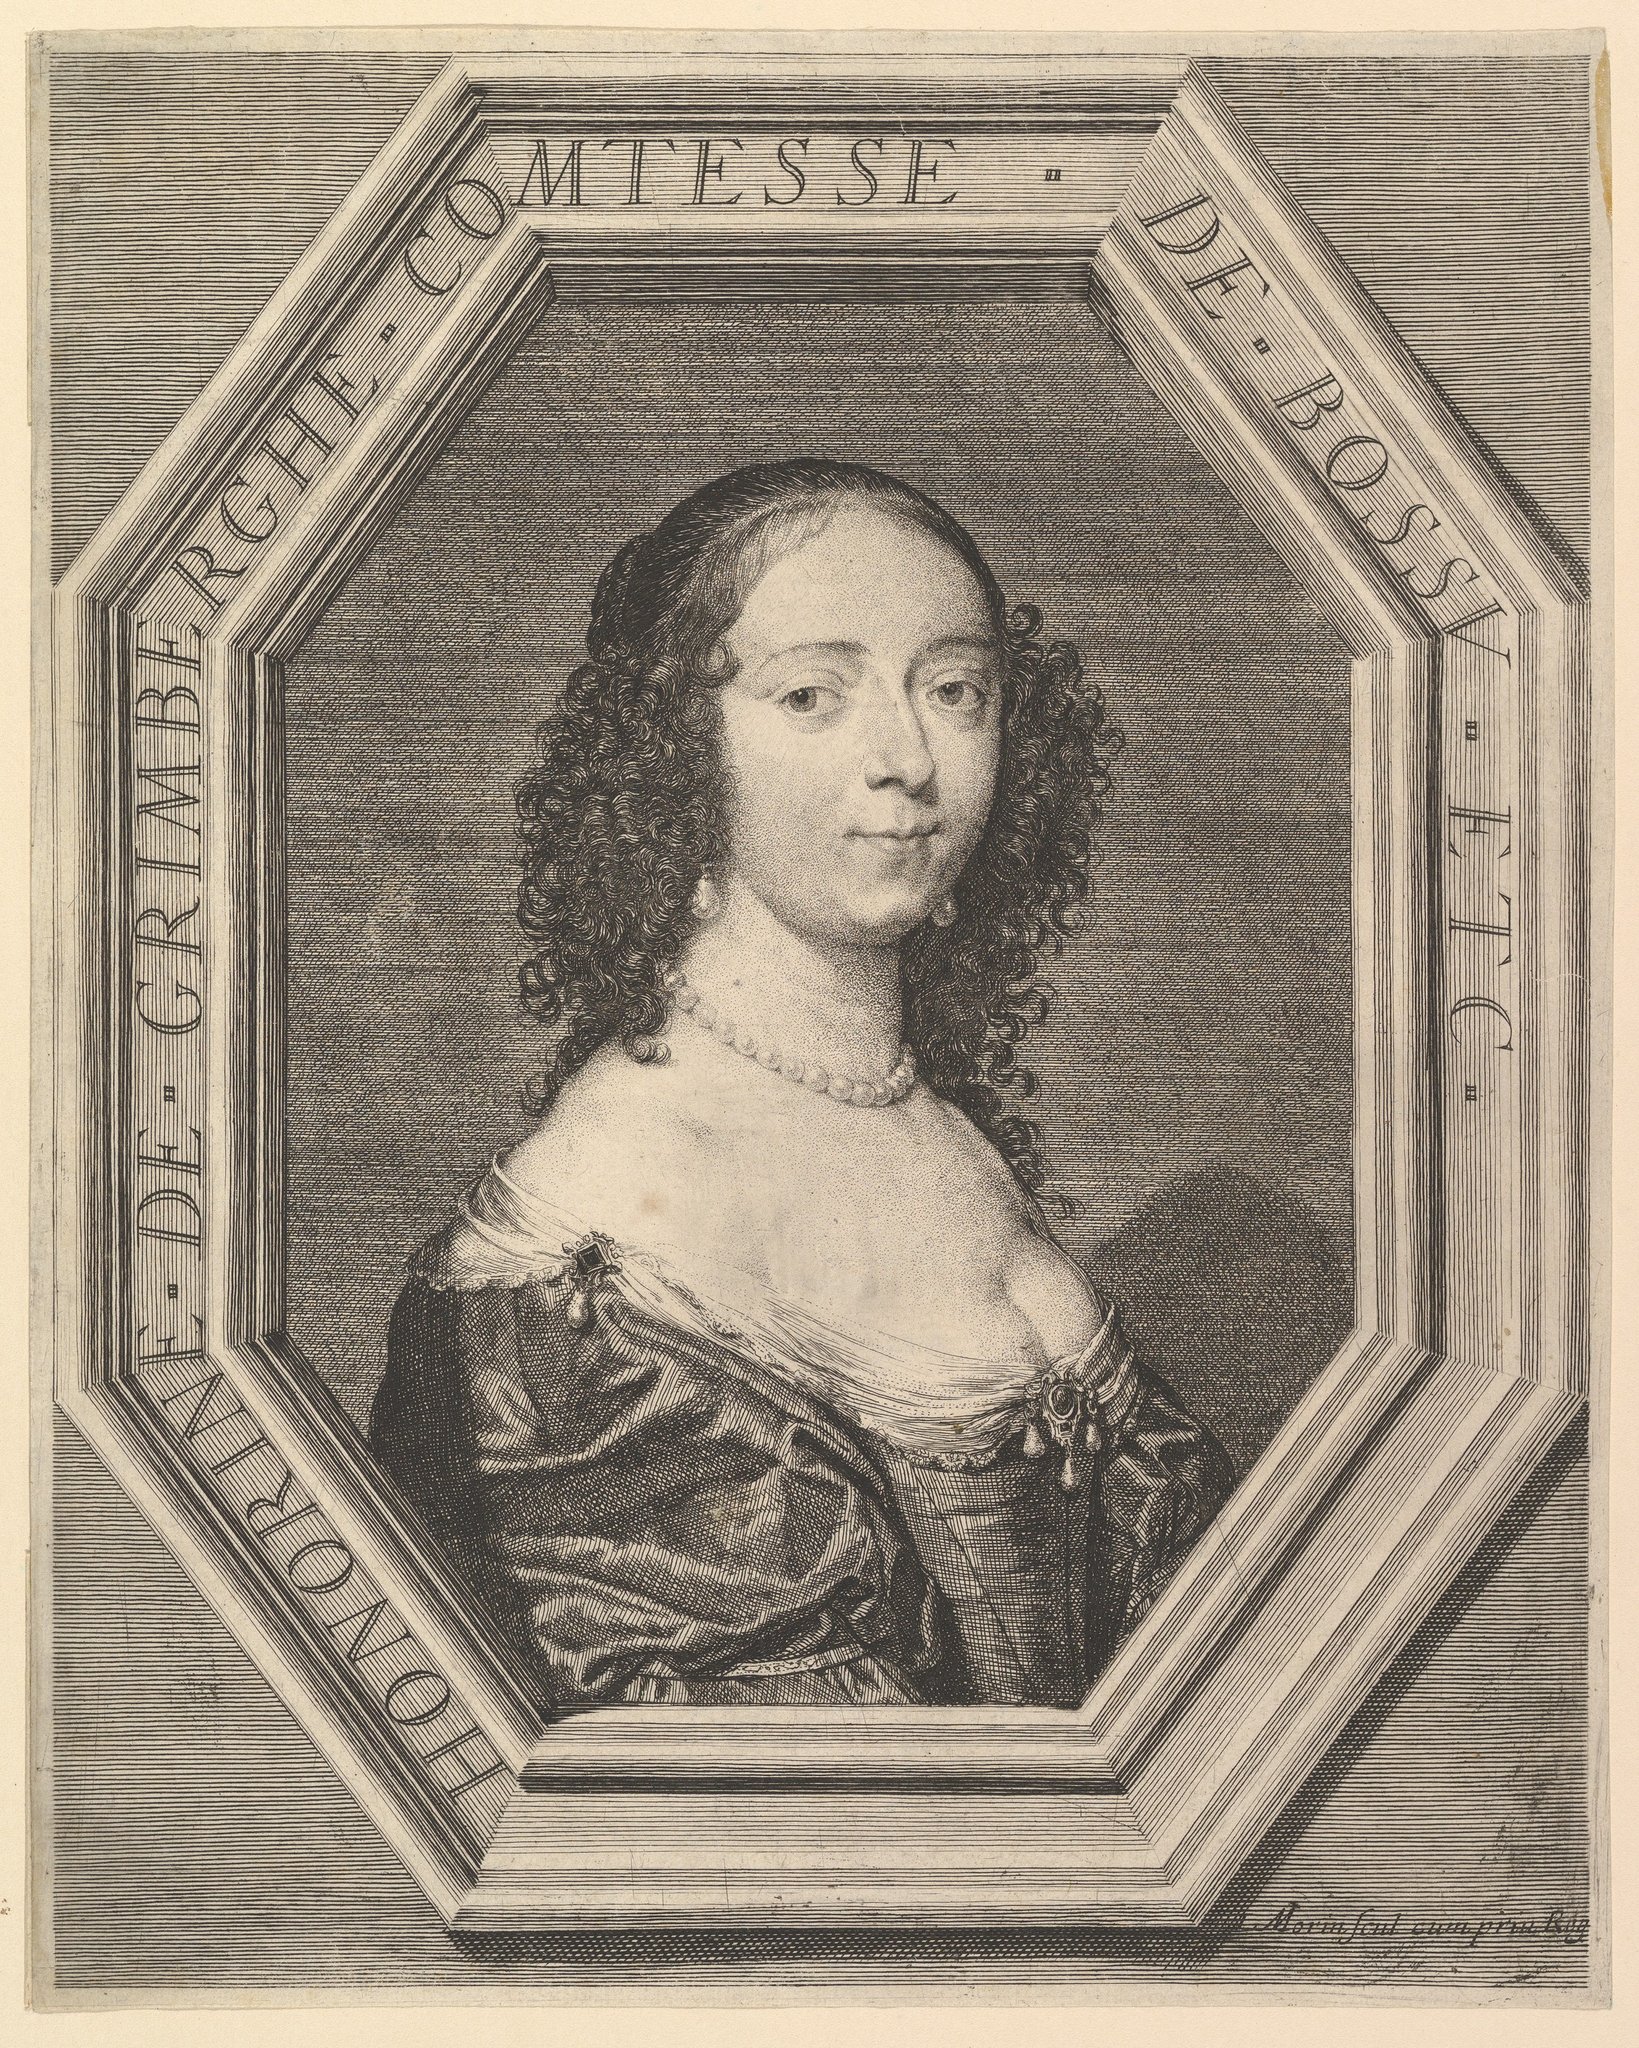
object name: print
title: Honorine de Grimberghe, comtesse du Bossu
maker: jean morin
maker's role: artist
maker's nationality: french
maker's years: 1605-1650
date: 1605-1650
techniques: etching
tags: portraits,women